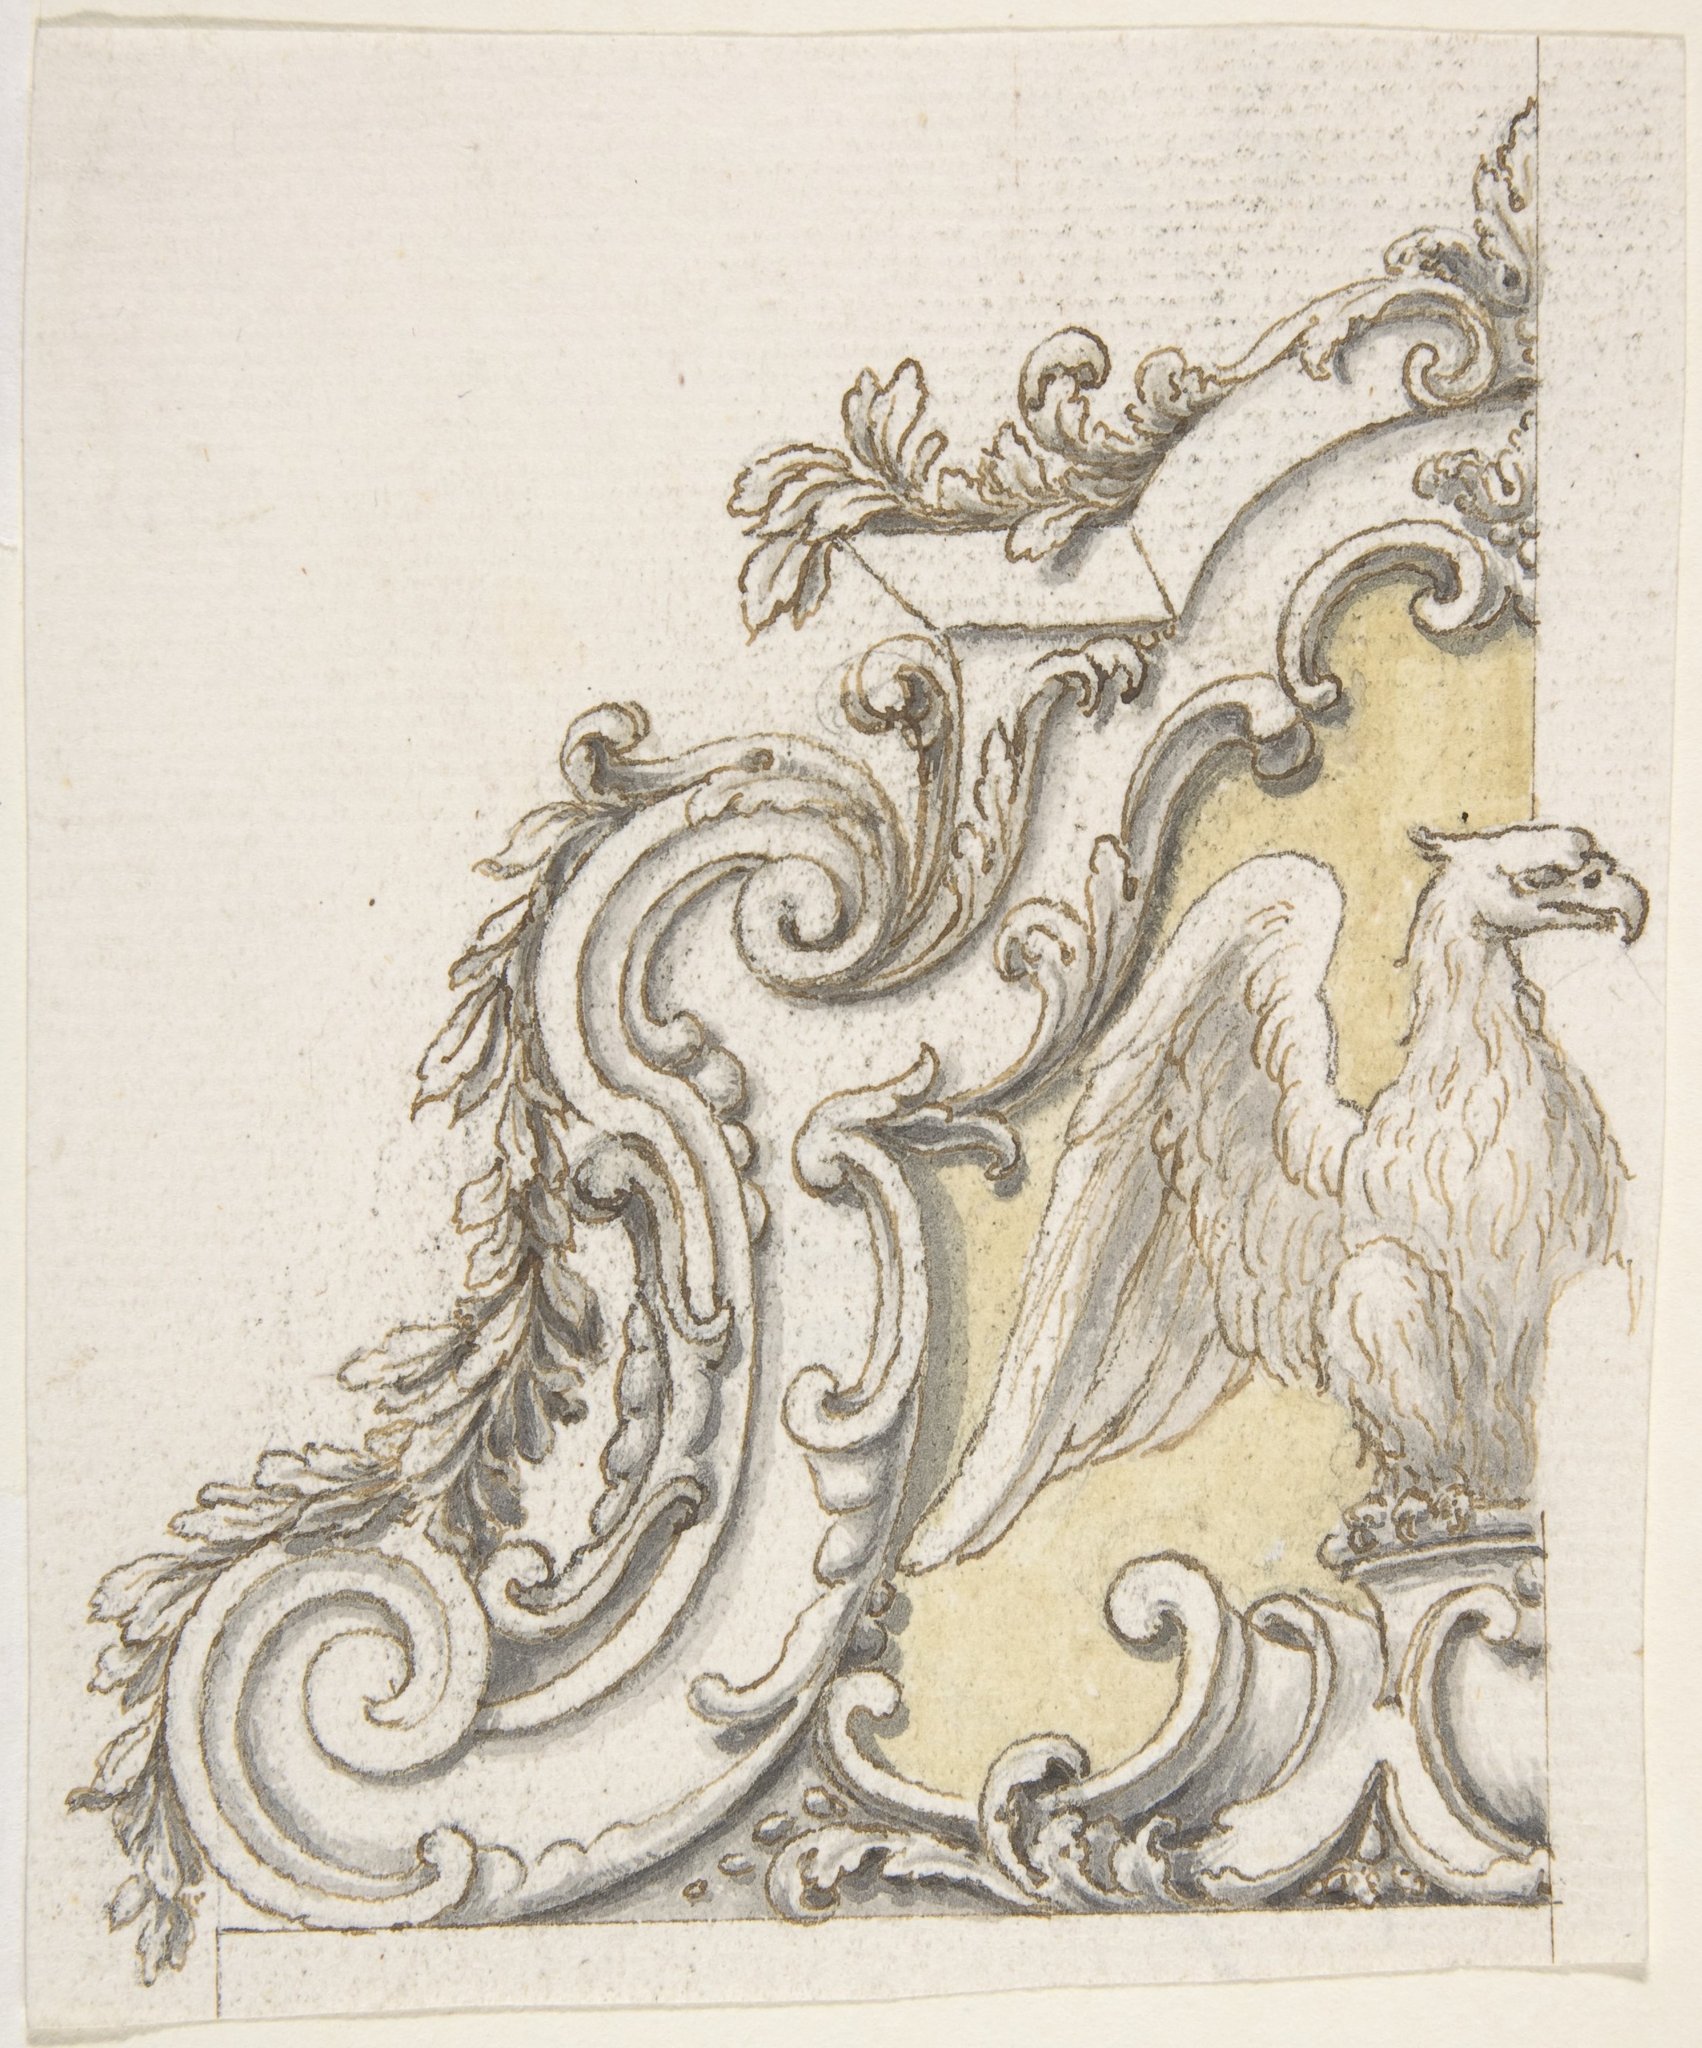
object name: ornament architecture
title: Design for a Sculptural Ornament With an Eagle, Volutes and Leaves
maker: giovanni battista foggini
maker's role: artist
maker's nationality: italian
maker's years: 1652-1725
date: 1652-1725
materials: ink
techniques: brush, pen, wash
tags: eagles,leaves